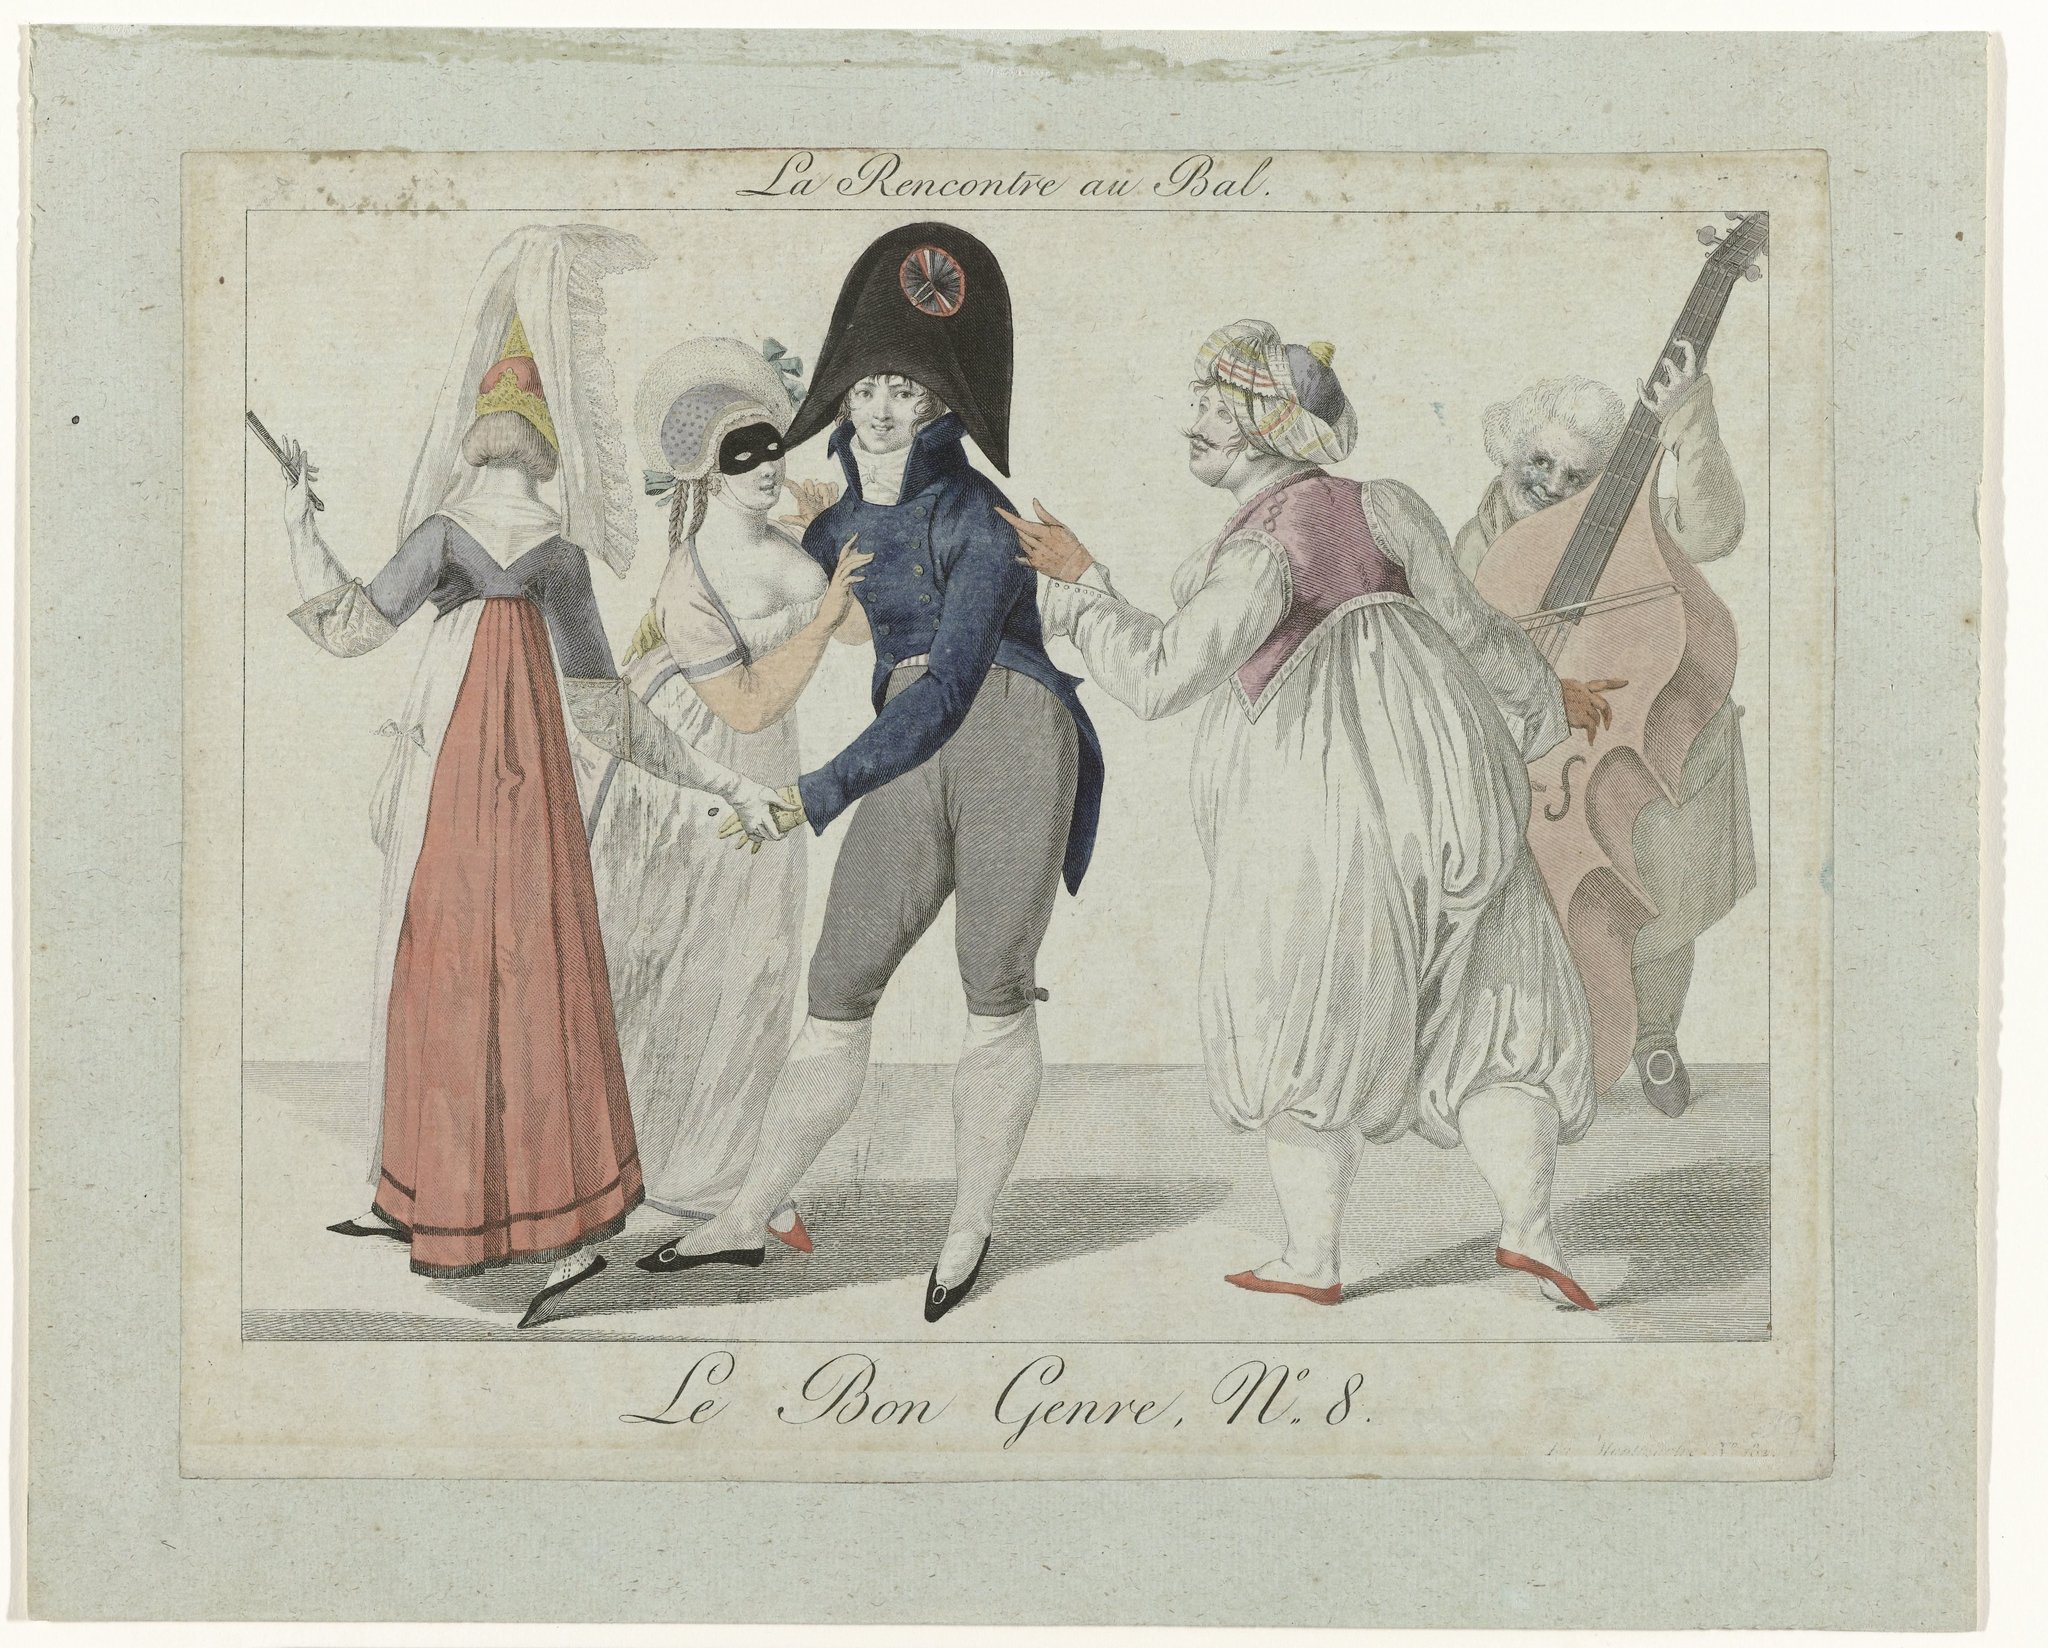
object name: fashion print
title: Le Bon Genre, No. 8 : La Rencontre au Bal.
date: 1801-1802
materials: paper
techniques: etching, engraving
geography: paris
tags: fashion plates, dress, gown (+ women's clothes)